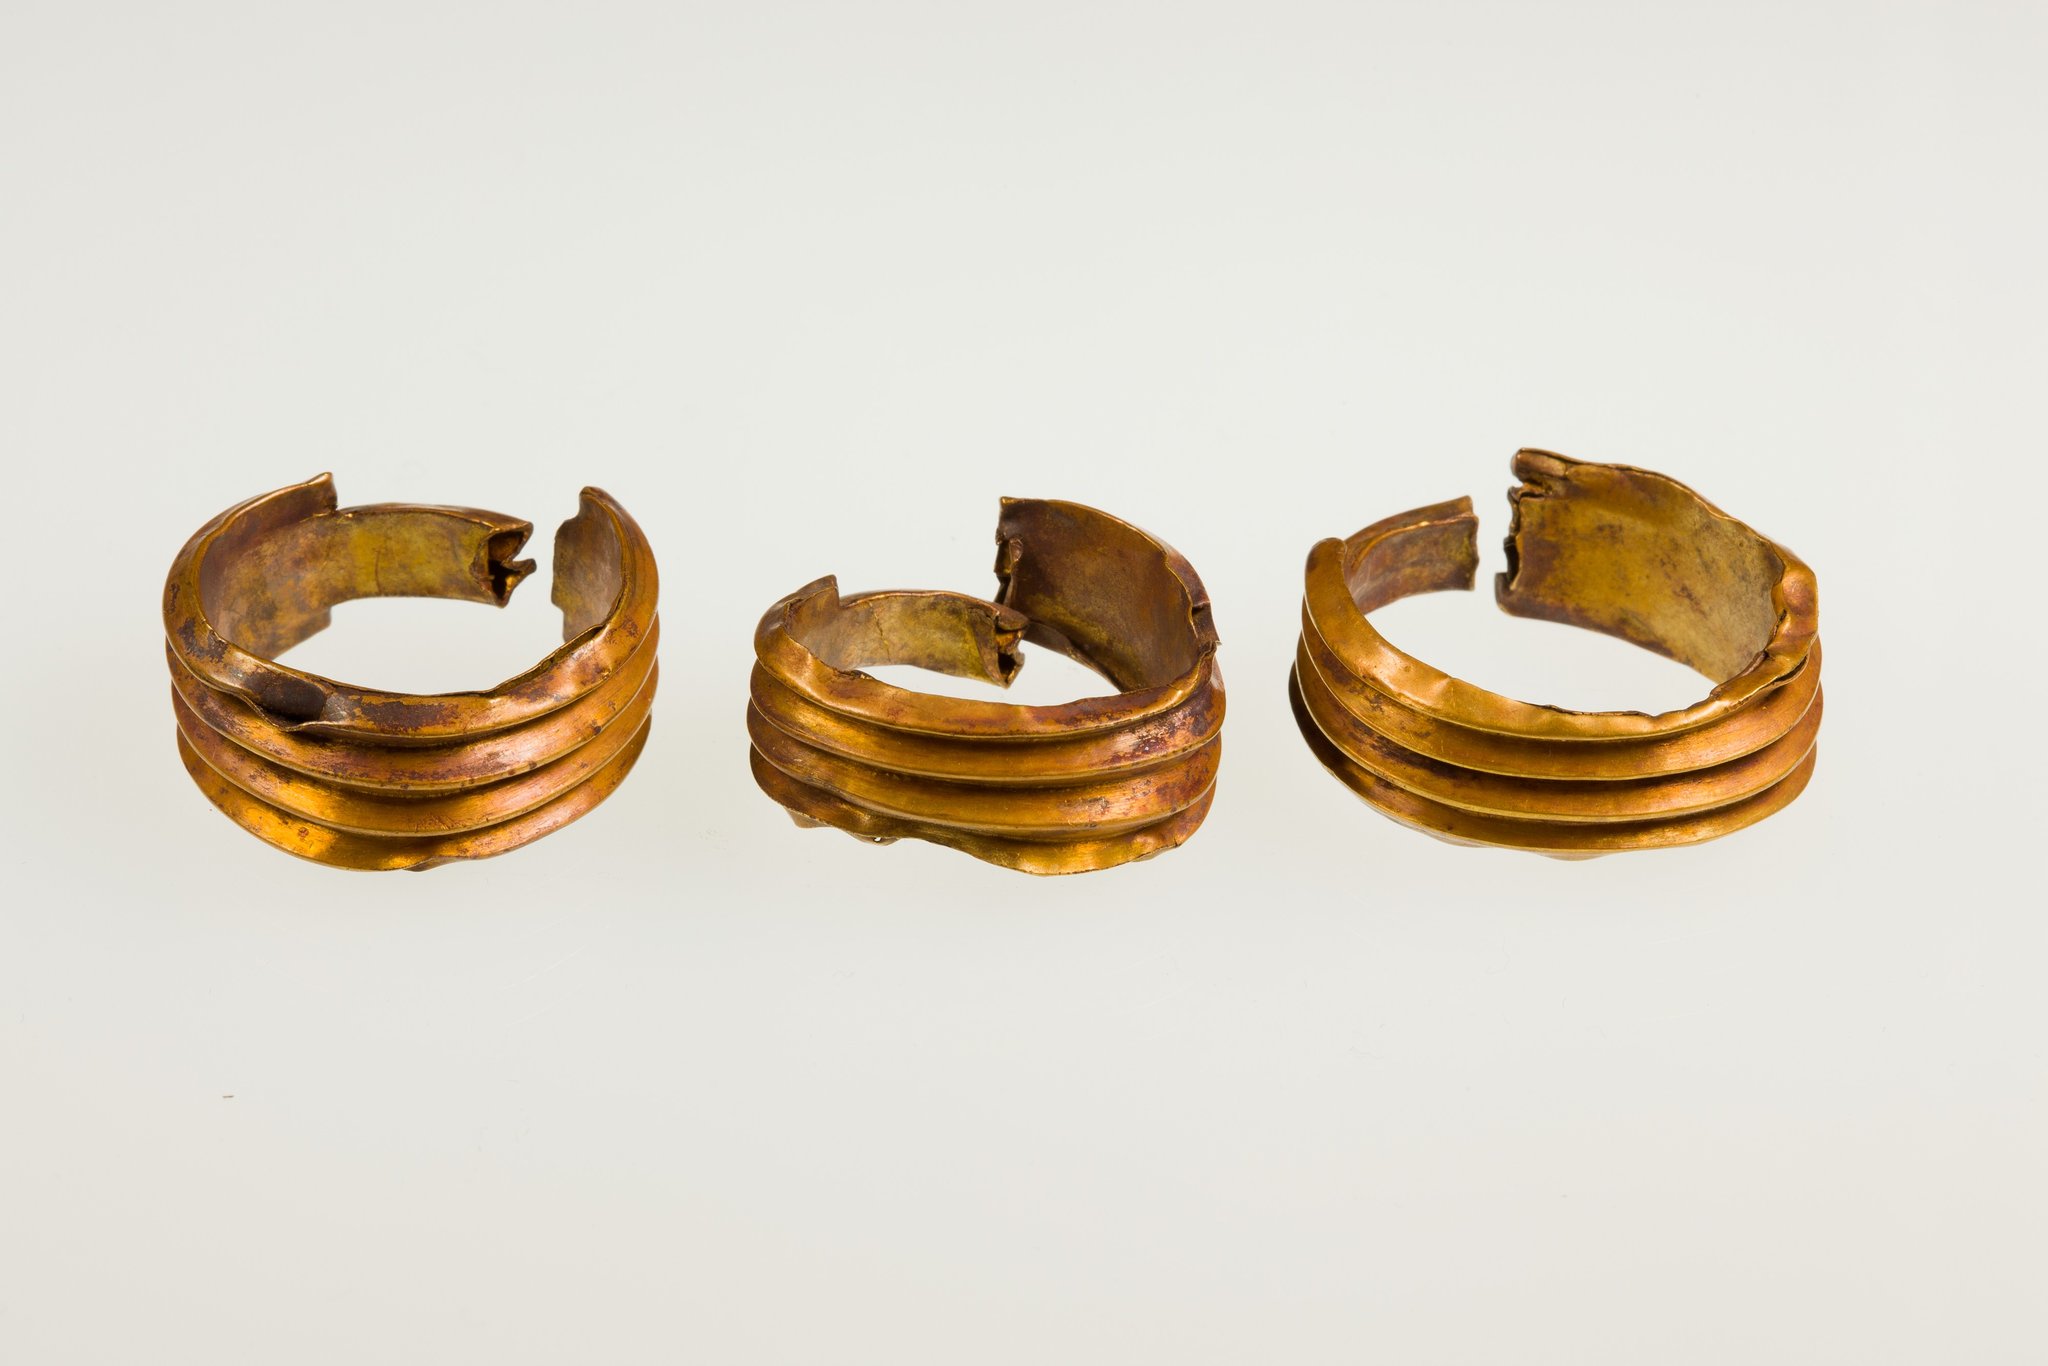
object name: earring, penannular, ribbed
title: Ribbed Penannular Earring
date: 1550-1425 BCE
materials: gold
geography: egypt